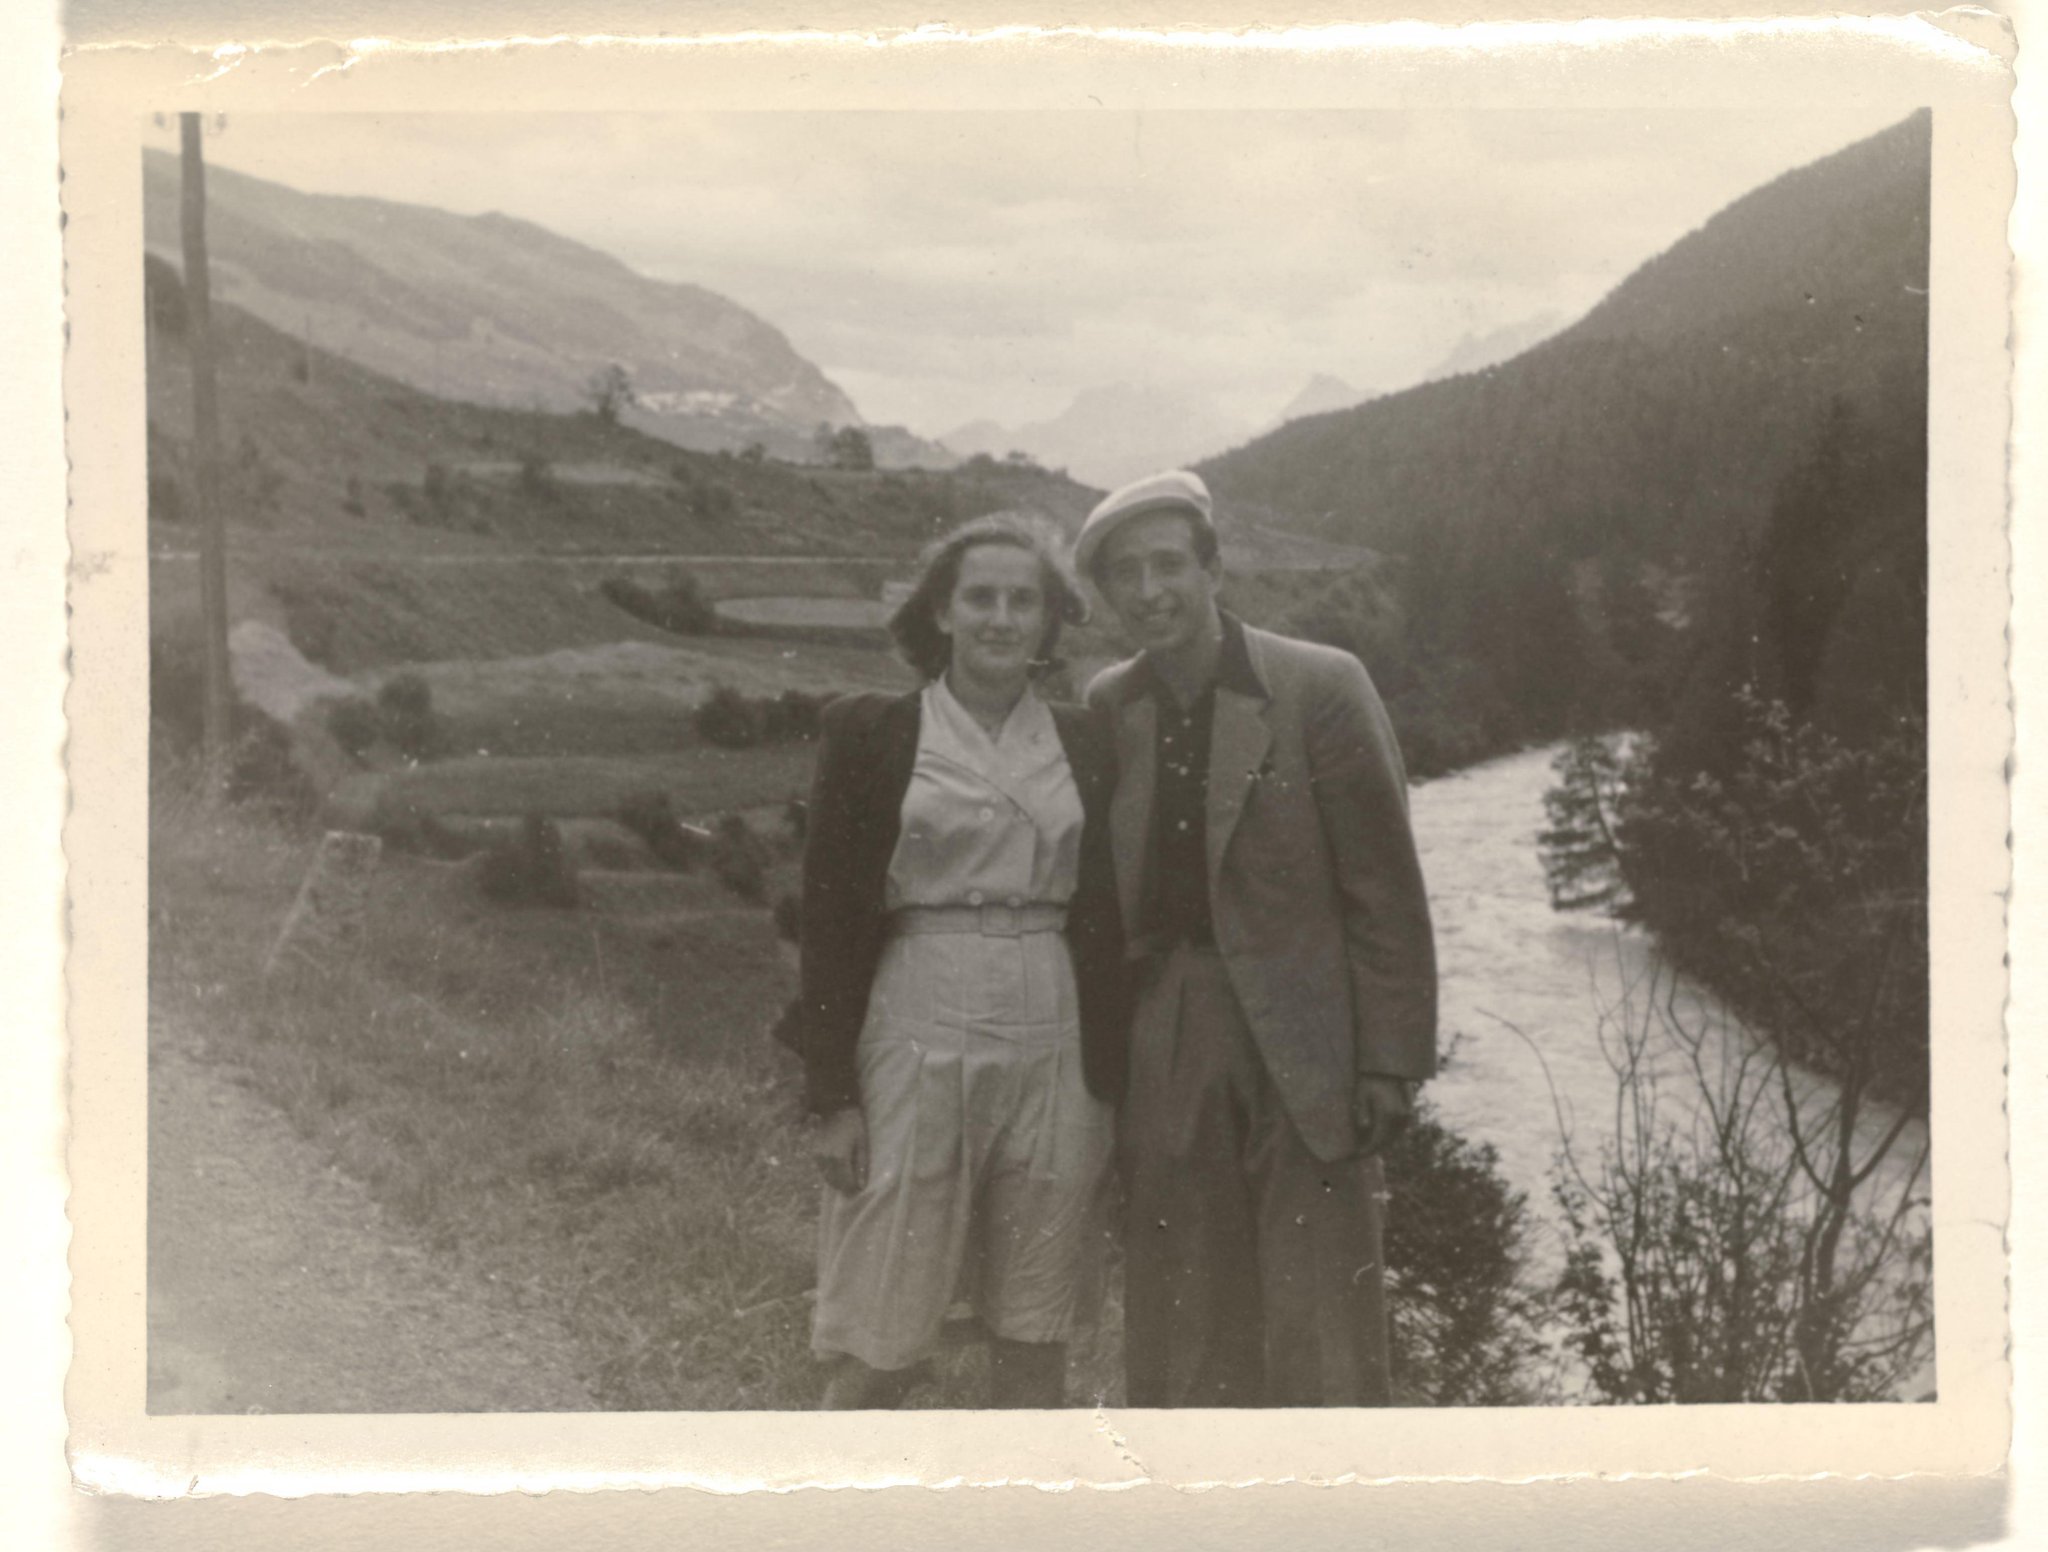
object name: photograph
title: Isabel Wachenheimer met Leo Blumensohn buiten in een bergachtige omgeving, 1945-1949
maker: Anonymous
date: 1945-1949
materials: photographic support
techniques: gelatin silver print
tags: leiden, isabel wachenheimer-elon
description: Isabel Wachenheimer in lichte kleding met Leo Blumensohn in pak en met alpinopet, buiten in een bergachtige omgeving.